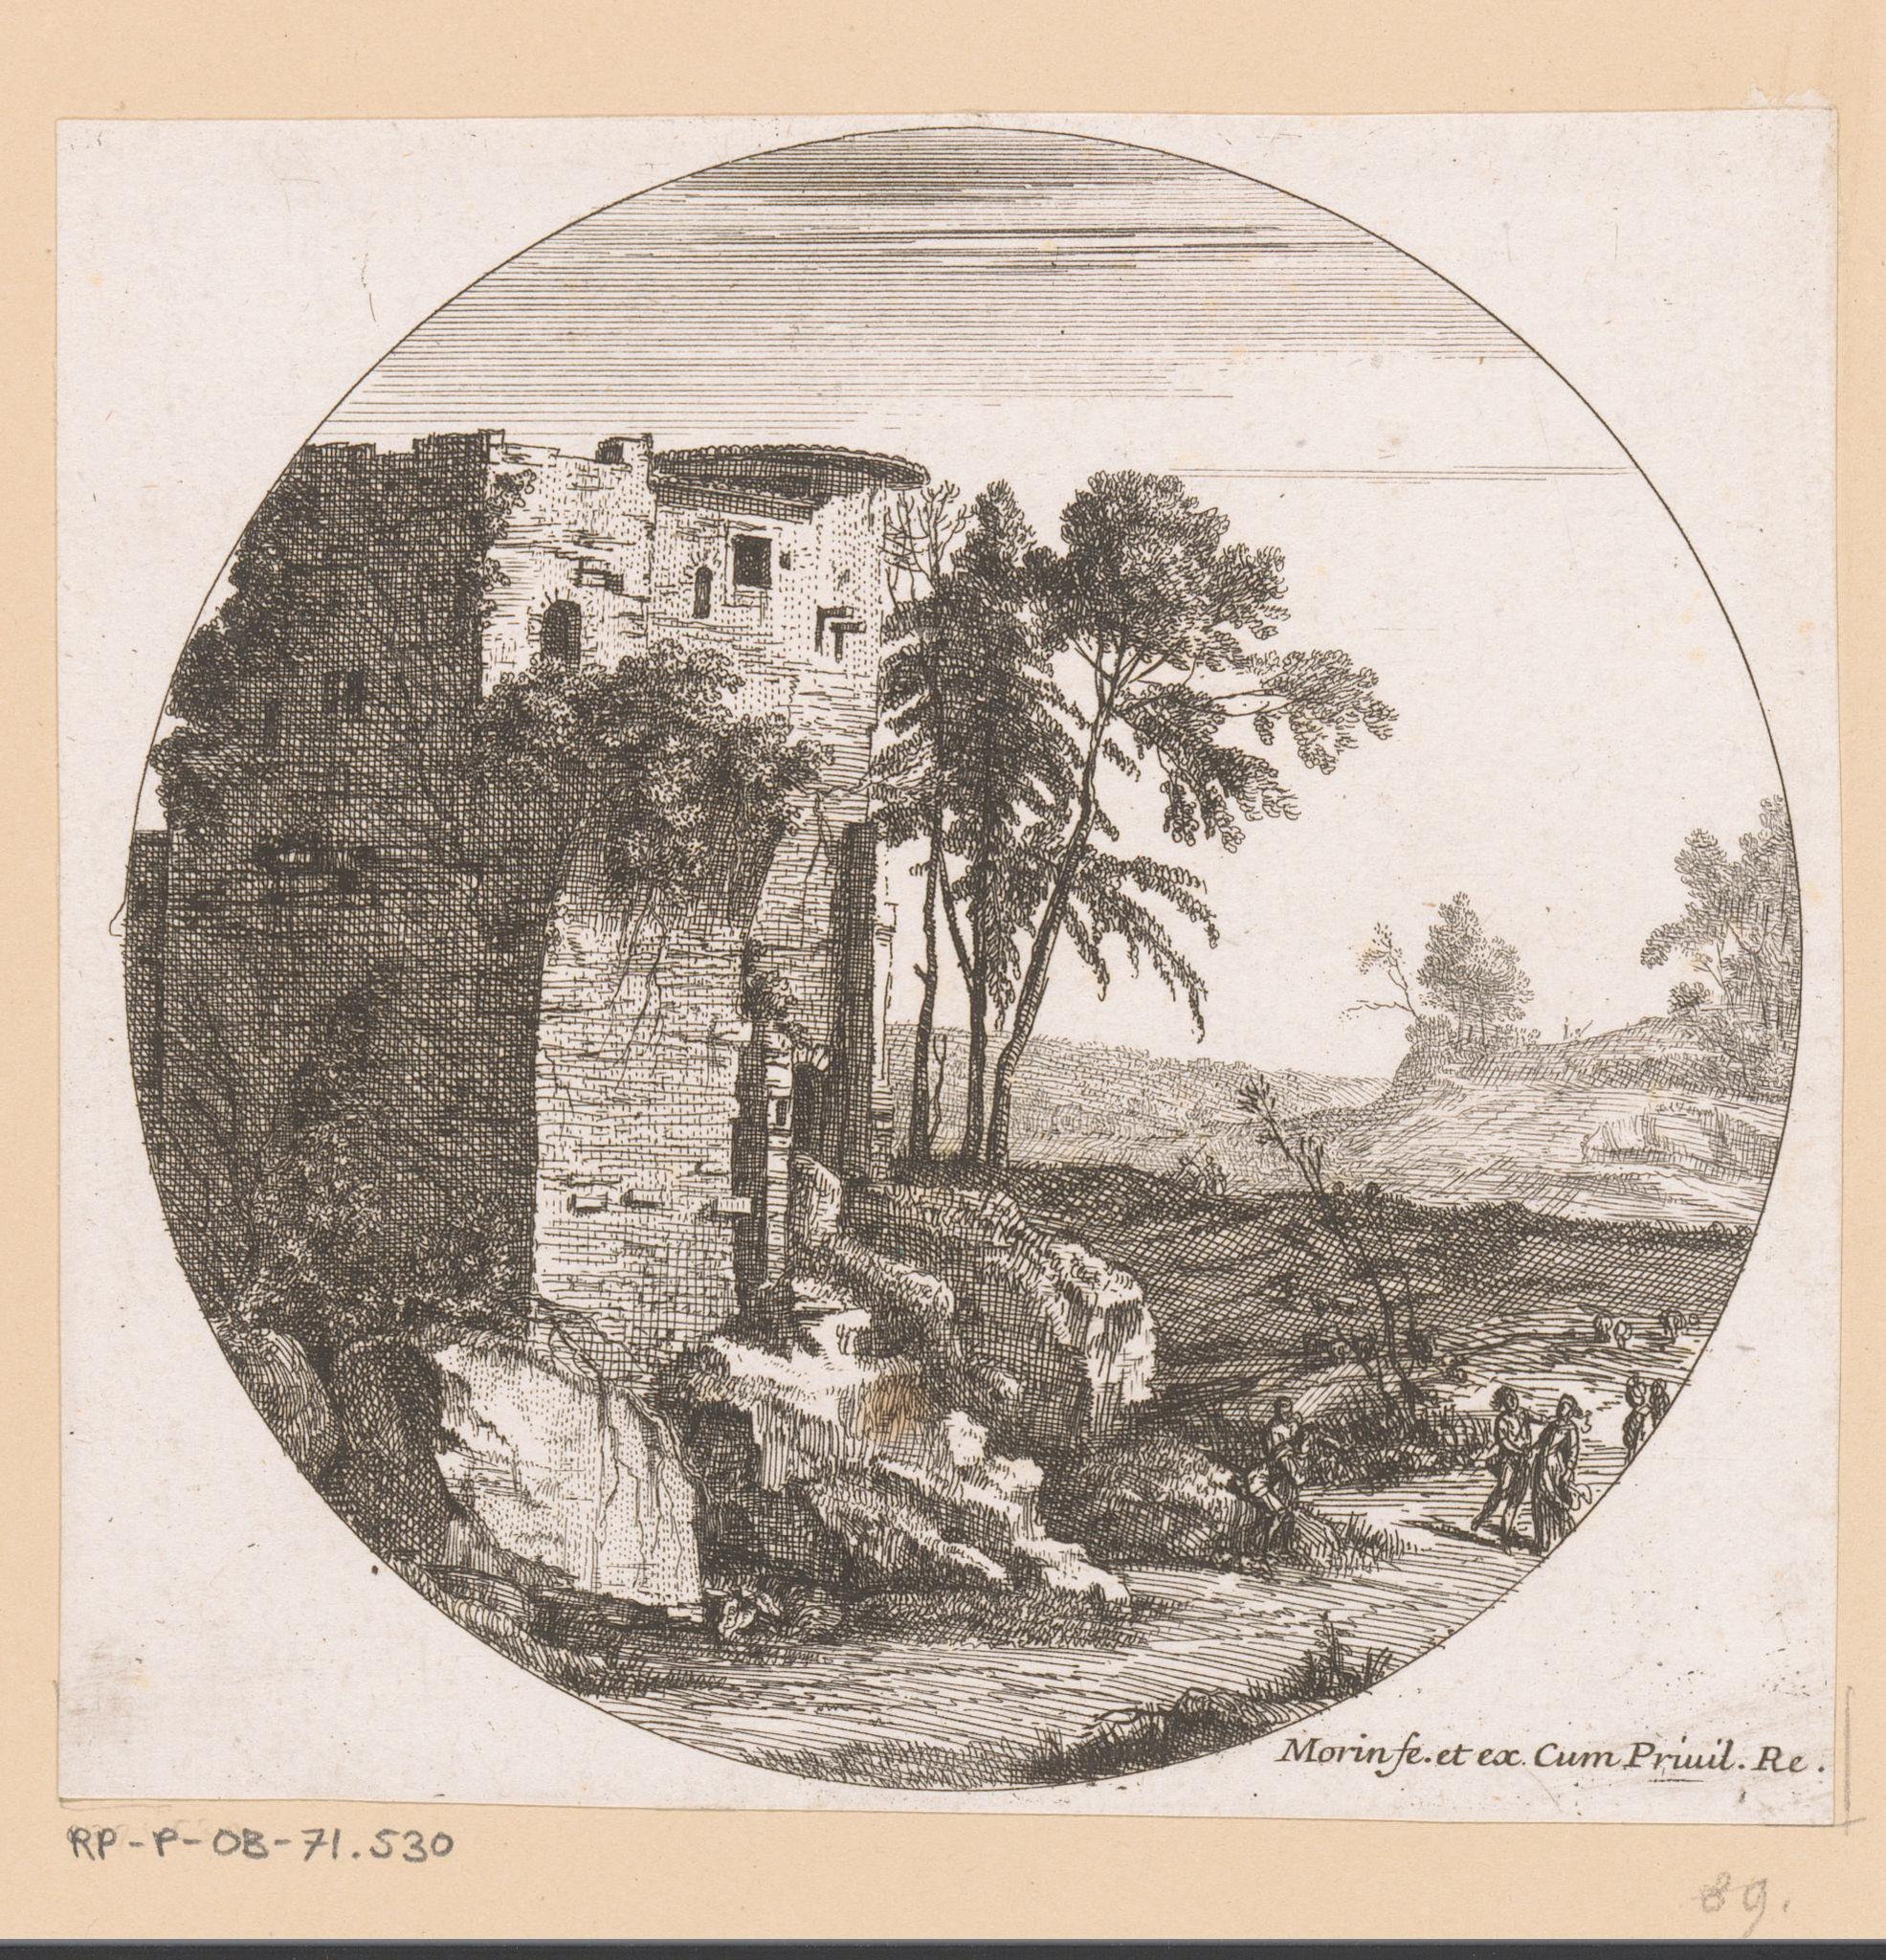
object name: print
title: Landschap met links ruïnes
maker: jean morin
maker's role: print maker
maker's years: 1605-1650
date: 1625-1650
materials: paper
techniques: etching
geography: france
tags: landscape with ruins, landscapes in the temperate zone (+ landscape with figures, staffage)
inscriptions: collector's mark: Lugt 240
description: Maakt deel uit van een zesdelige serie met landschappen in cirkels, uitgegeven door Morin.